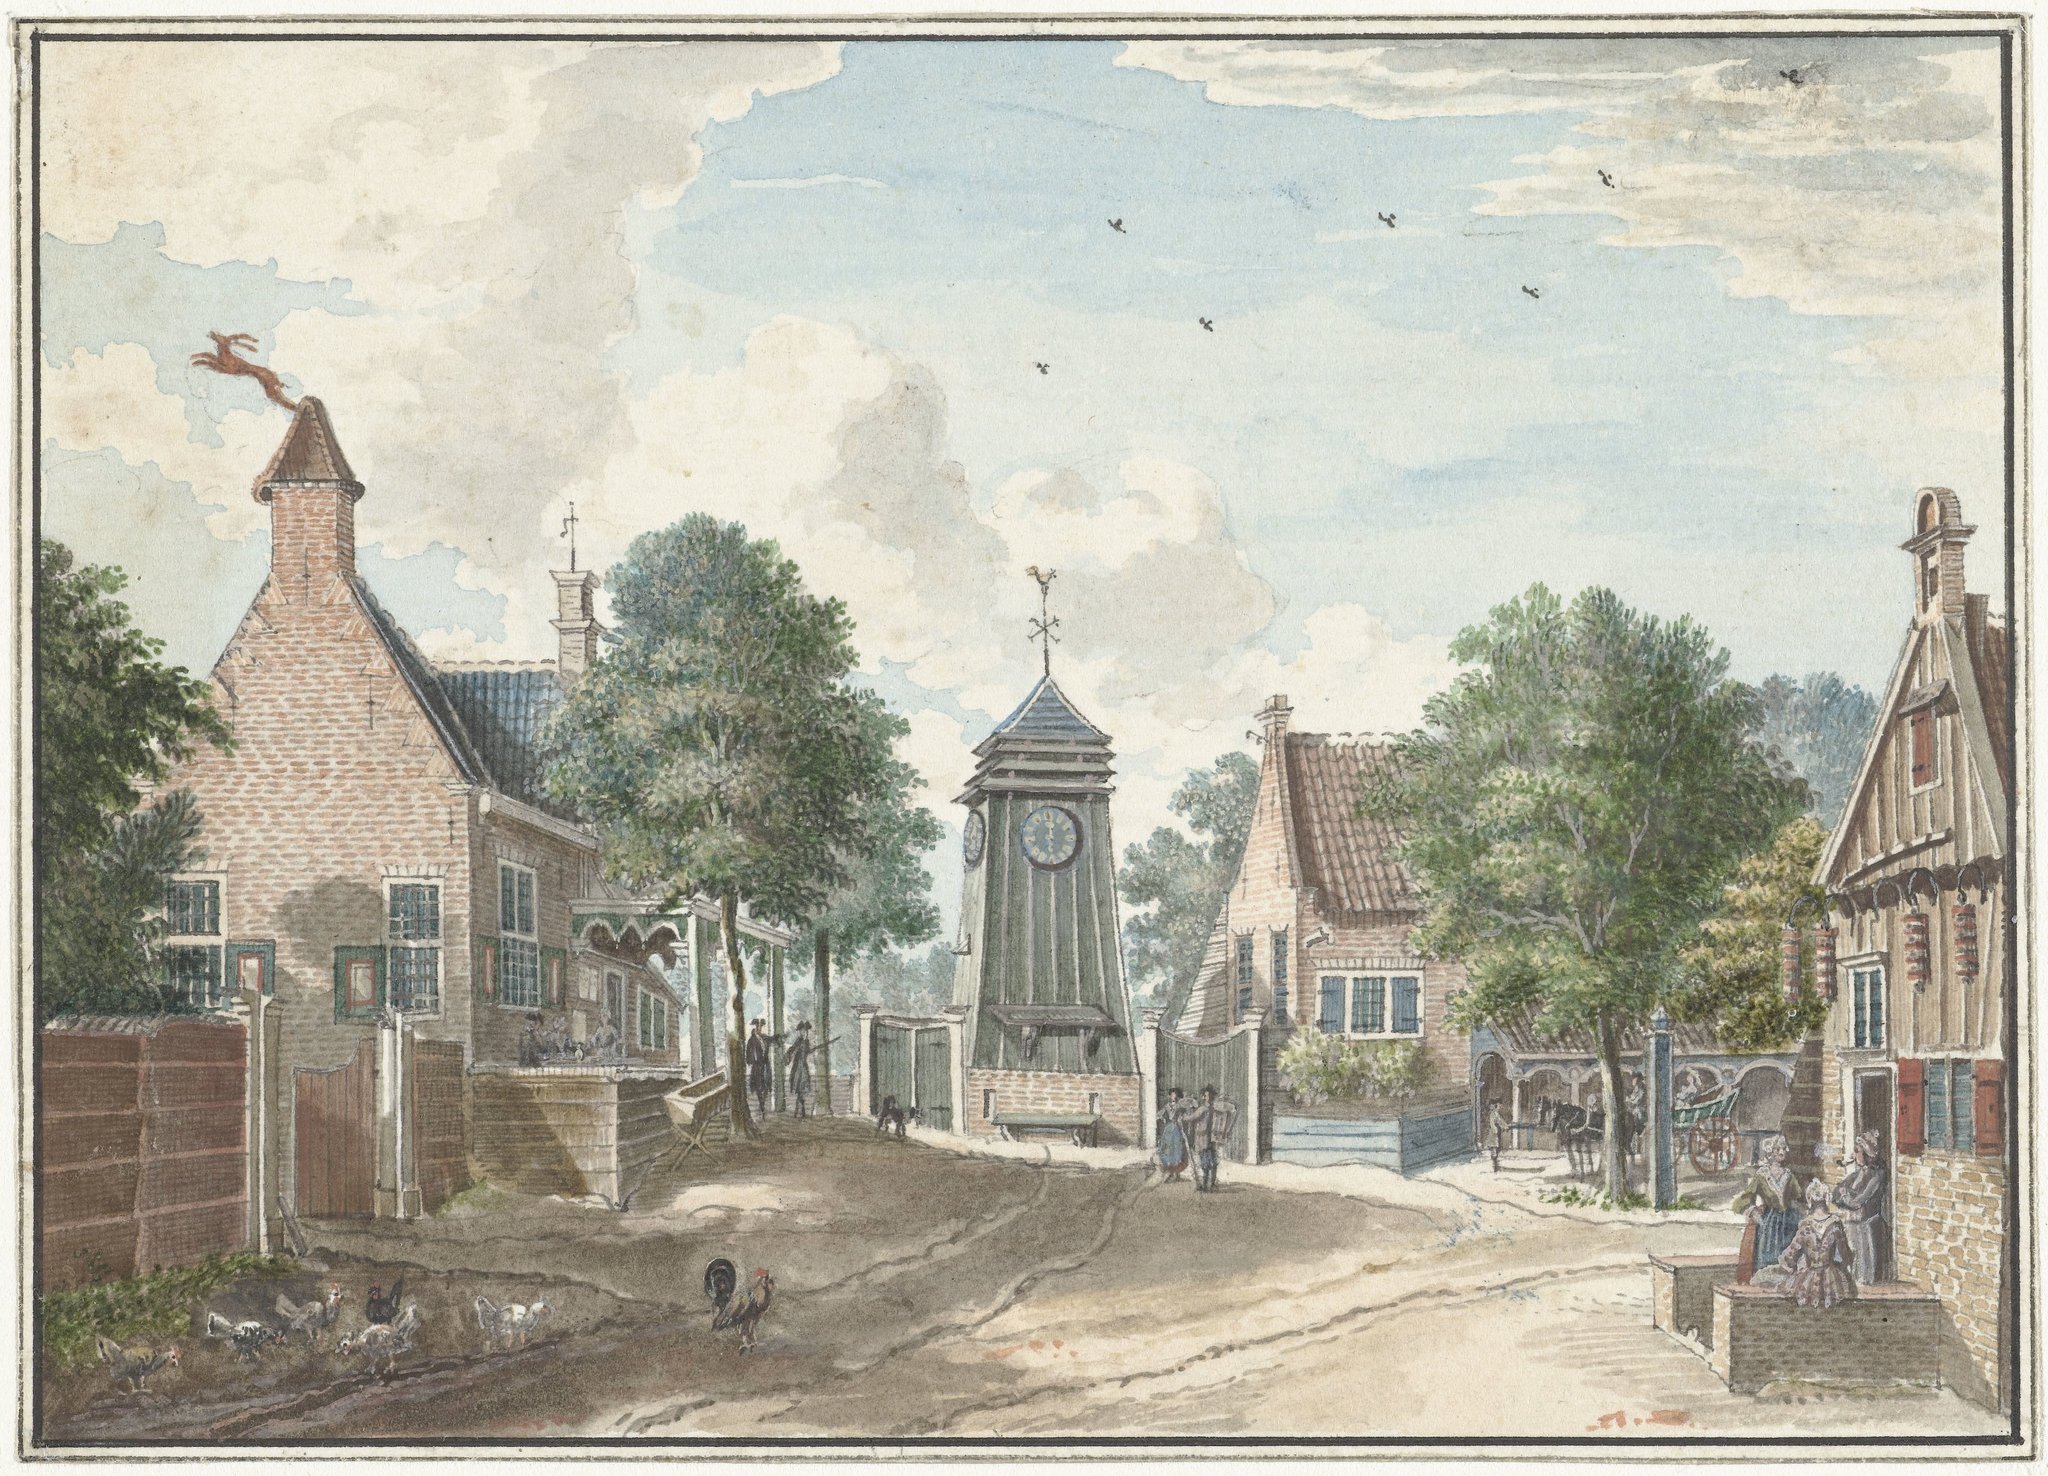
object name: watercolor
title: Gezicht op het Klokhuis te Overveen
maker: jan de beijer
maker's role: draughtsman, print maker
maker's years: 1703-1780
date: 1713-1780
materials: ink, paper, watercolor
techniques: brush, pen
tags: clock, public road